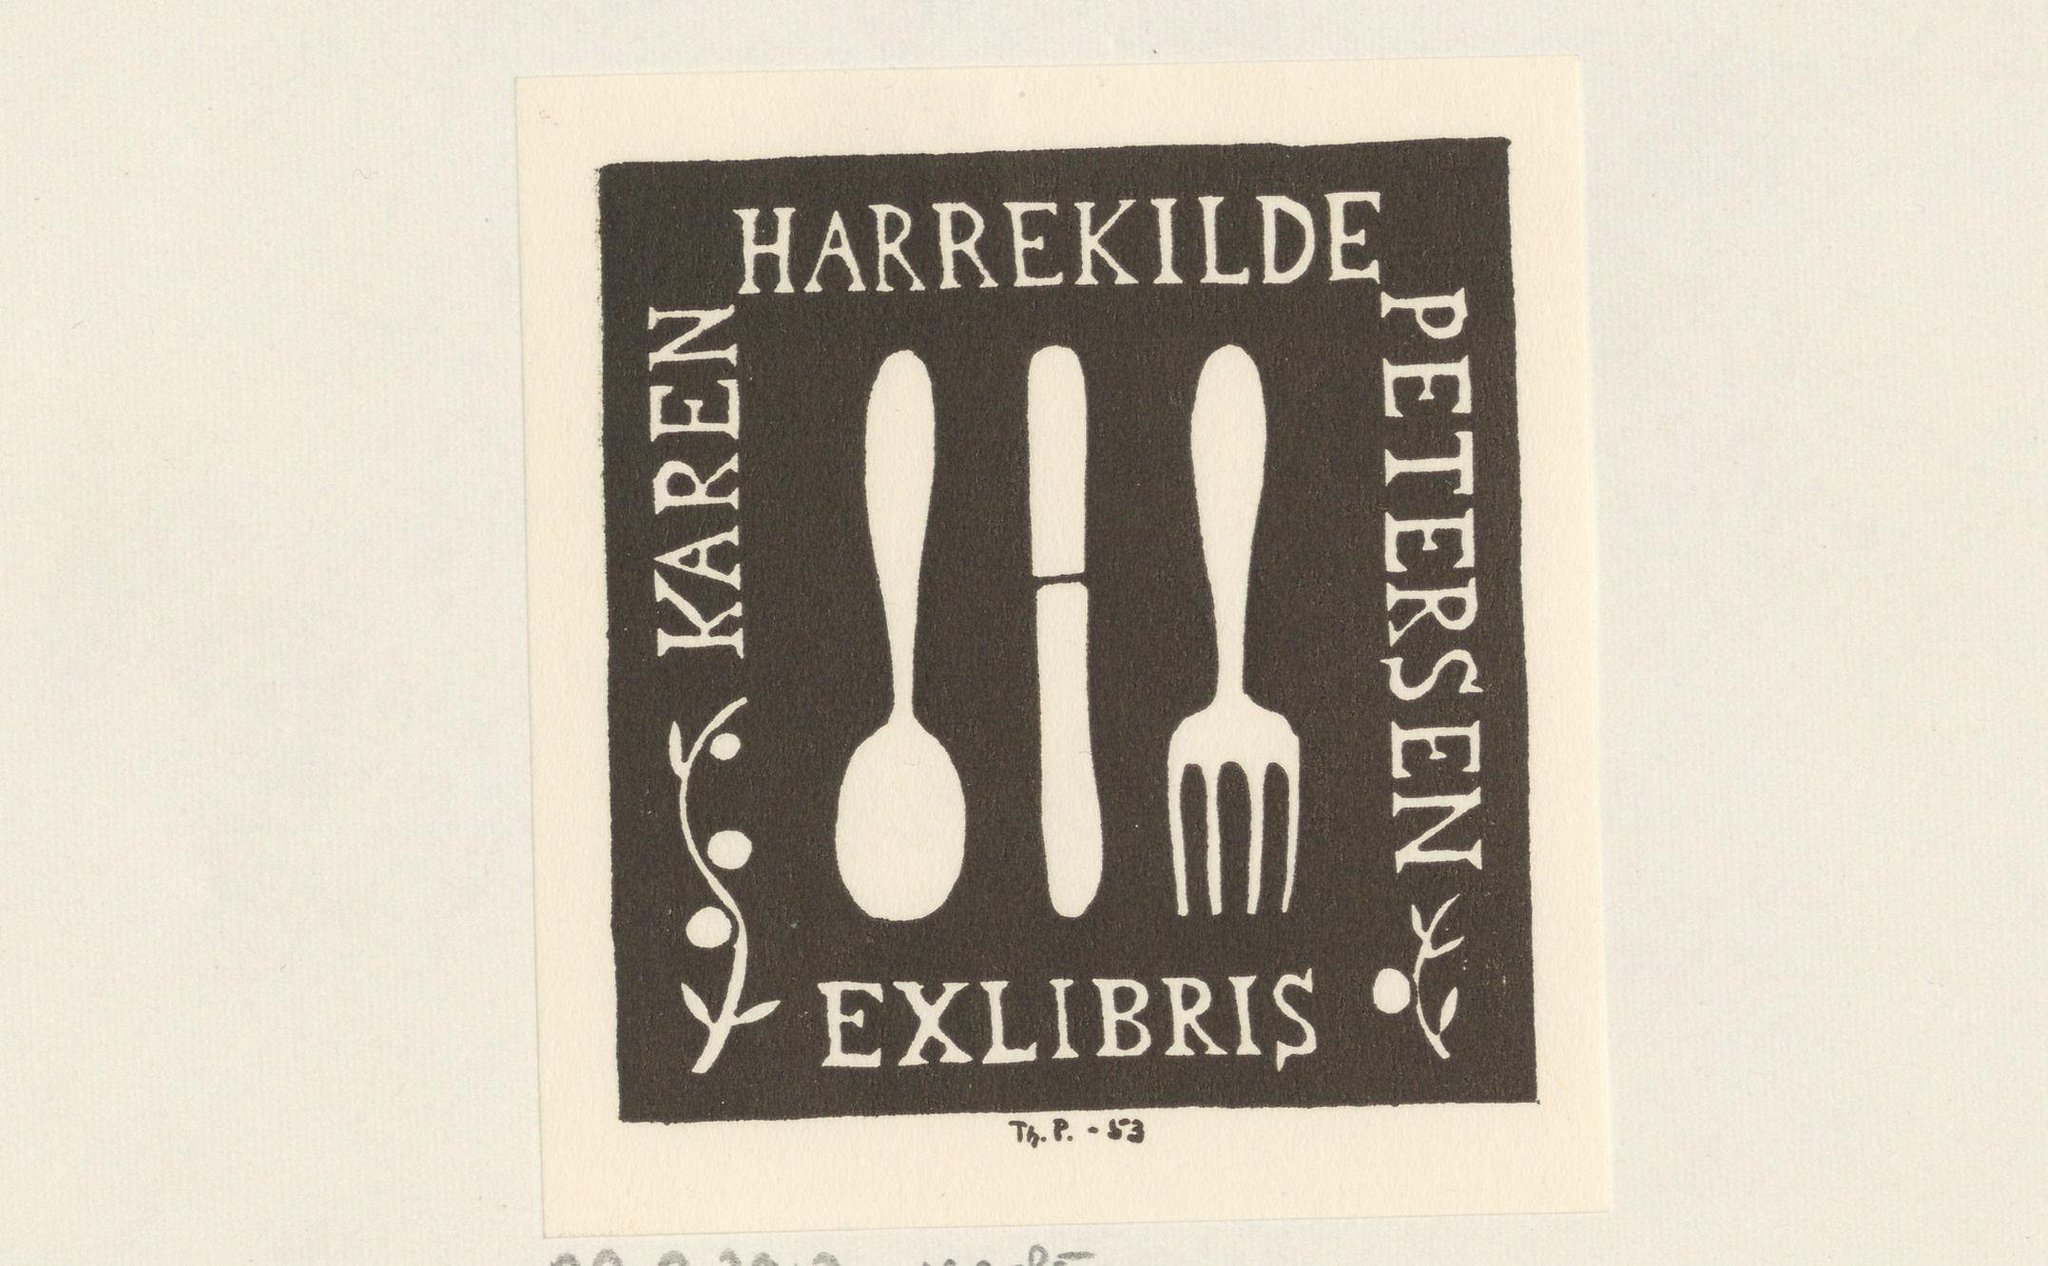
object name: bookplate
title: Ex libris van Karen Harrekilde-Petersen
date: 1953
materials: paper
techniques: printing block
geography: denmark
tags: table-ware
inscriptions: date